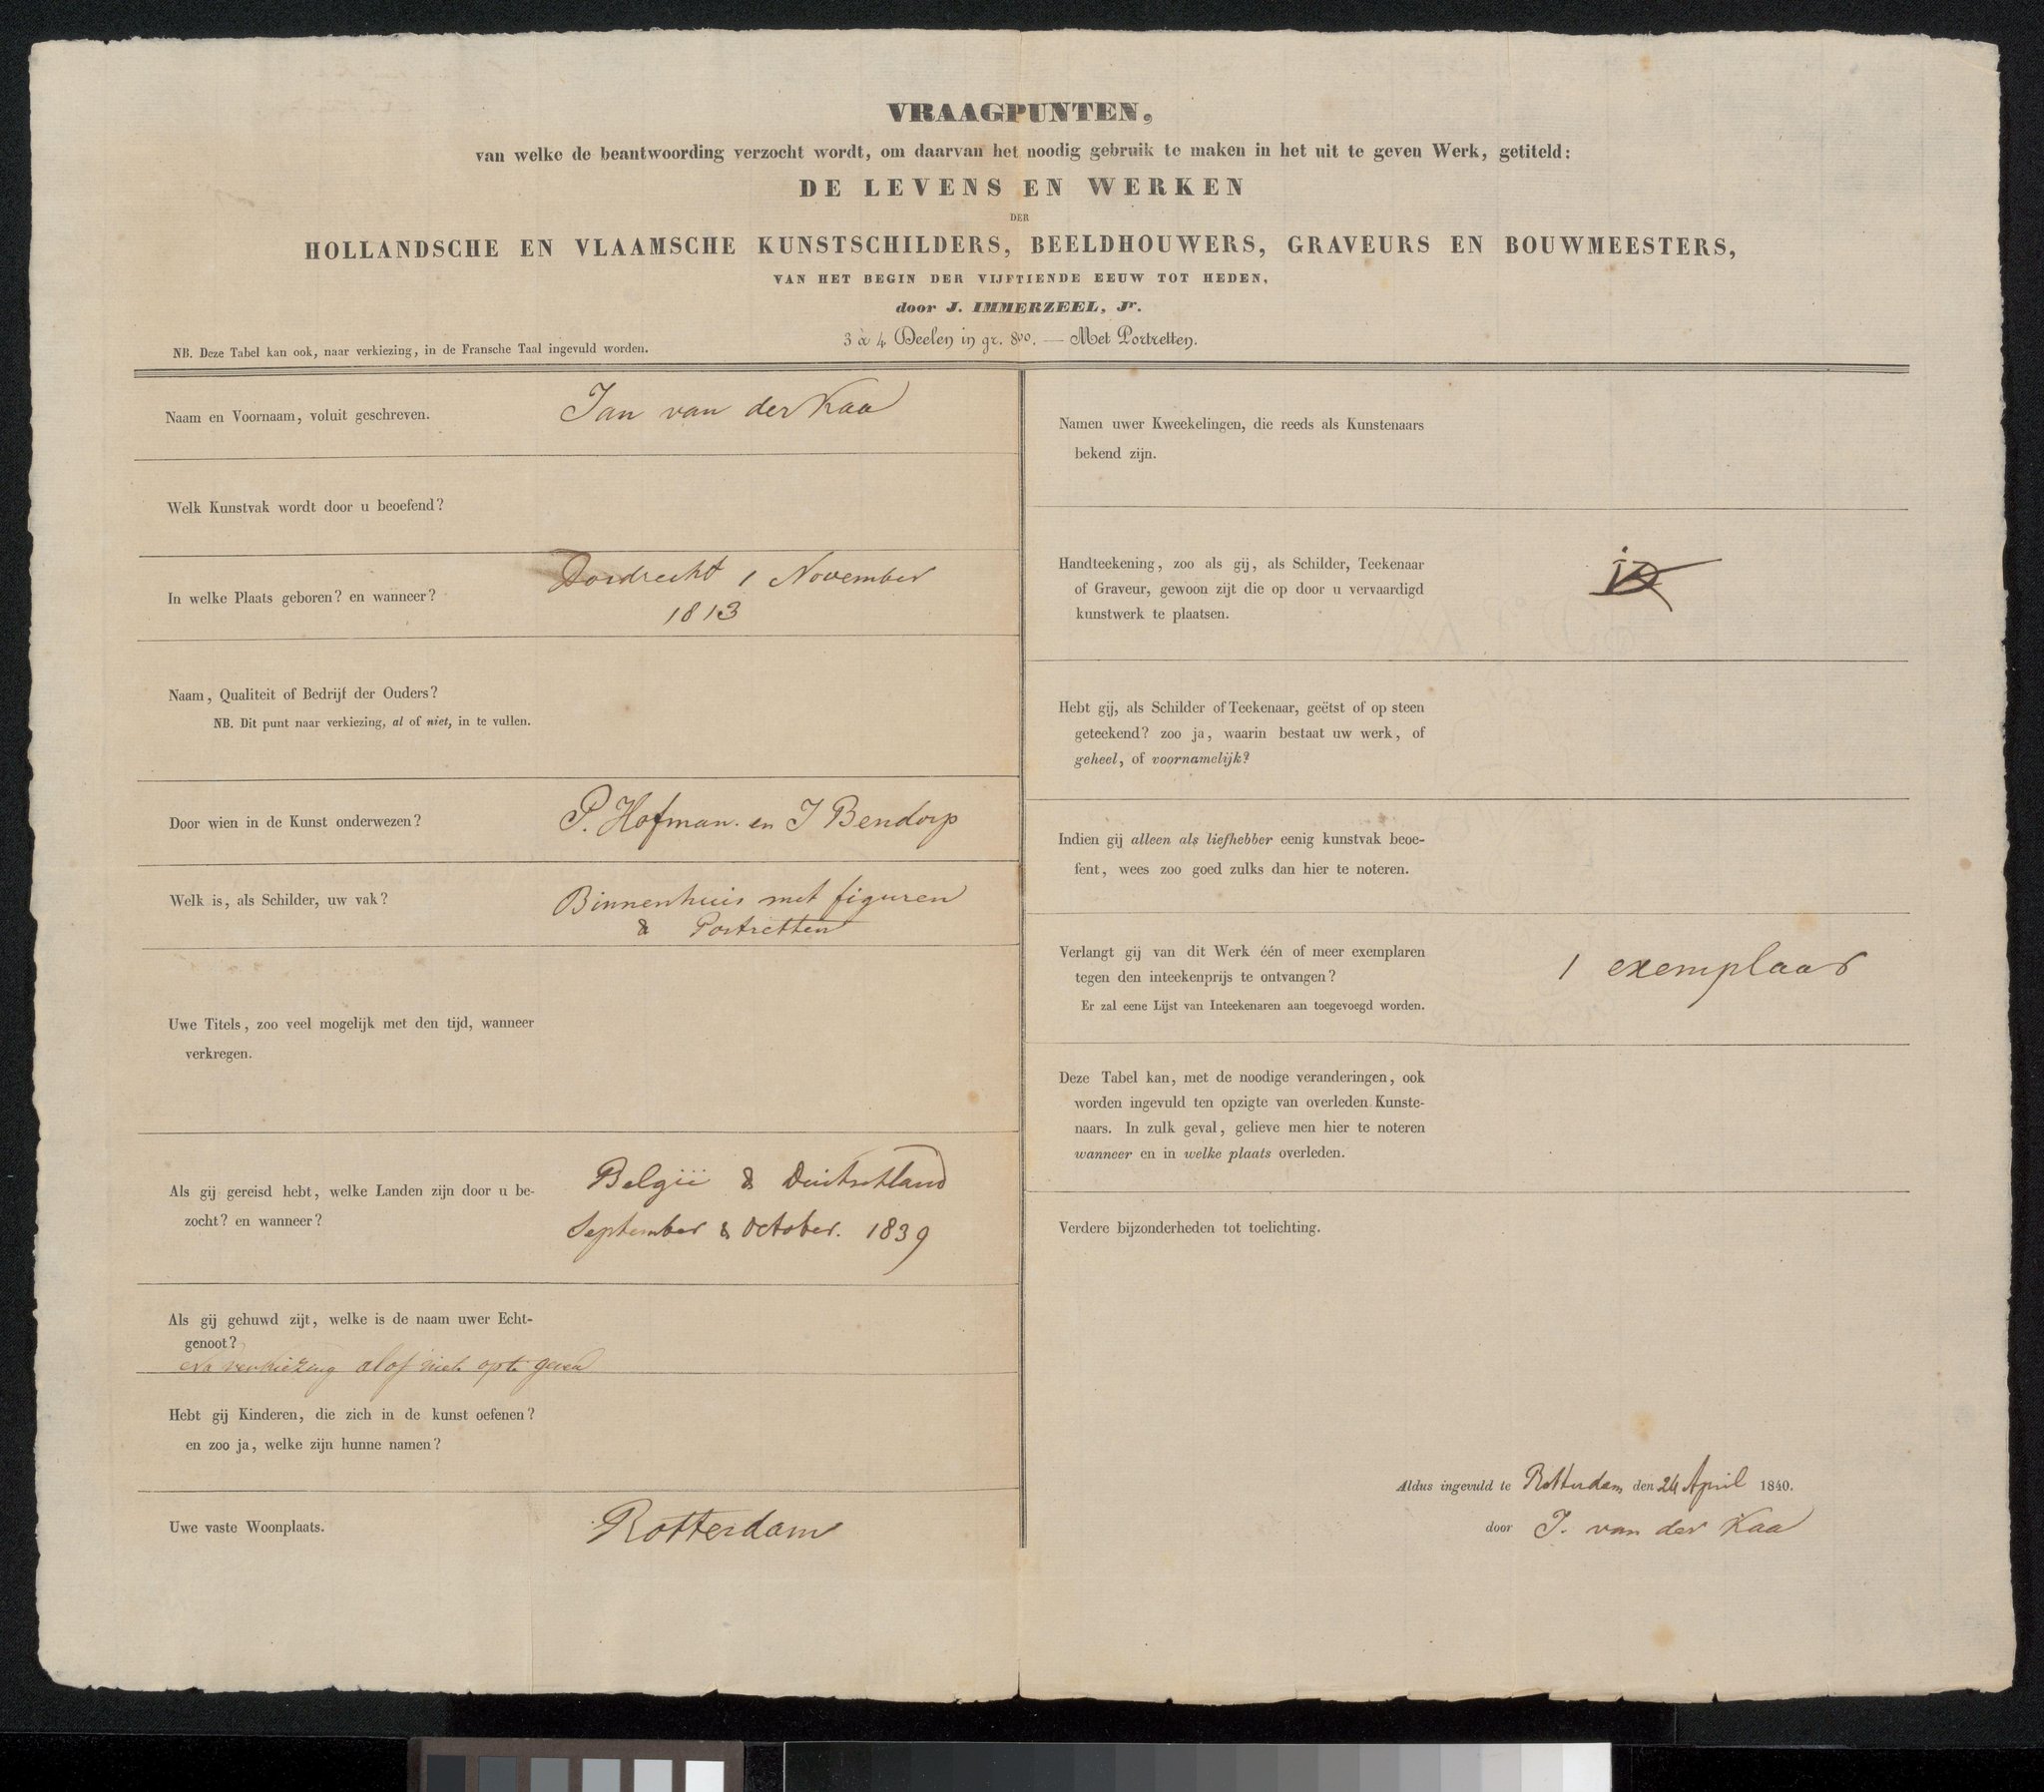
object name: questionnaire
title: Enquêteformulier ingevuld door Jan van der Kaa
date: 1840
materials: ink, paper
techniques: pen, printing, writing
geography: rotterdam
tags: draughtsman, jan van der kaa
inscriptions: inscription: ‘Vraagpunten,/ van welke de beantwoording verzocht wordt, om daarvan het noodig gebruik te maken in het uit te geven Werk, getiteld: De levens en werken/ der Hollandsche en Vlaamsche kunstschilders, beeldhouwers,/ graveurs en bouwmeesters, van het begin der vijftiende eeuw tot heden/ door J. Immerzeel, Jr.’, watermark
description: Opgenomen in: Immerzeel, J. Jr., De levens en werken der Hollandsche en Vlaamsche kunstschilders, beeldhouwers, graveurs en bouwmeesters, van het begin der vijftiende eeuw tot heden, Amsterdam: J.C. van Kesteren, 1842-1843.